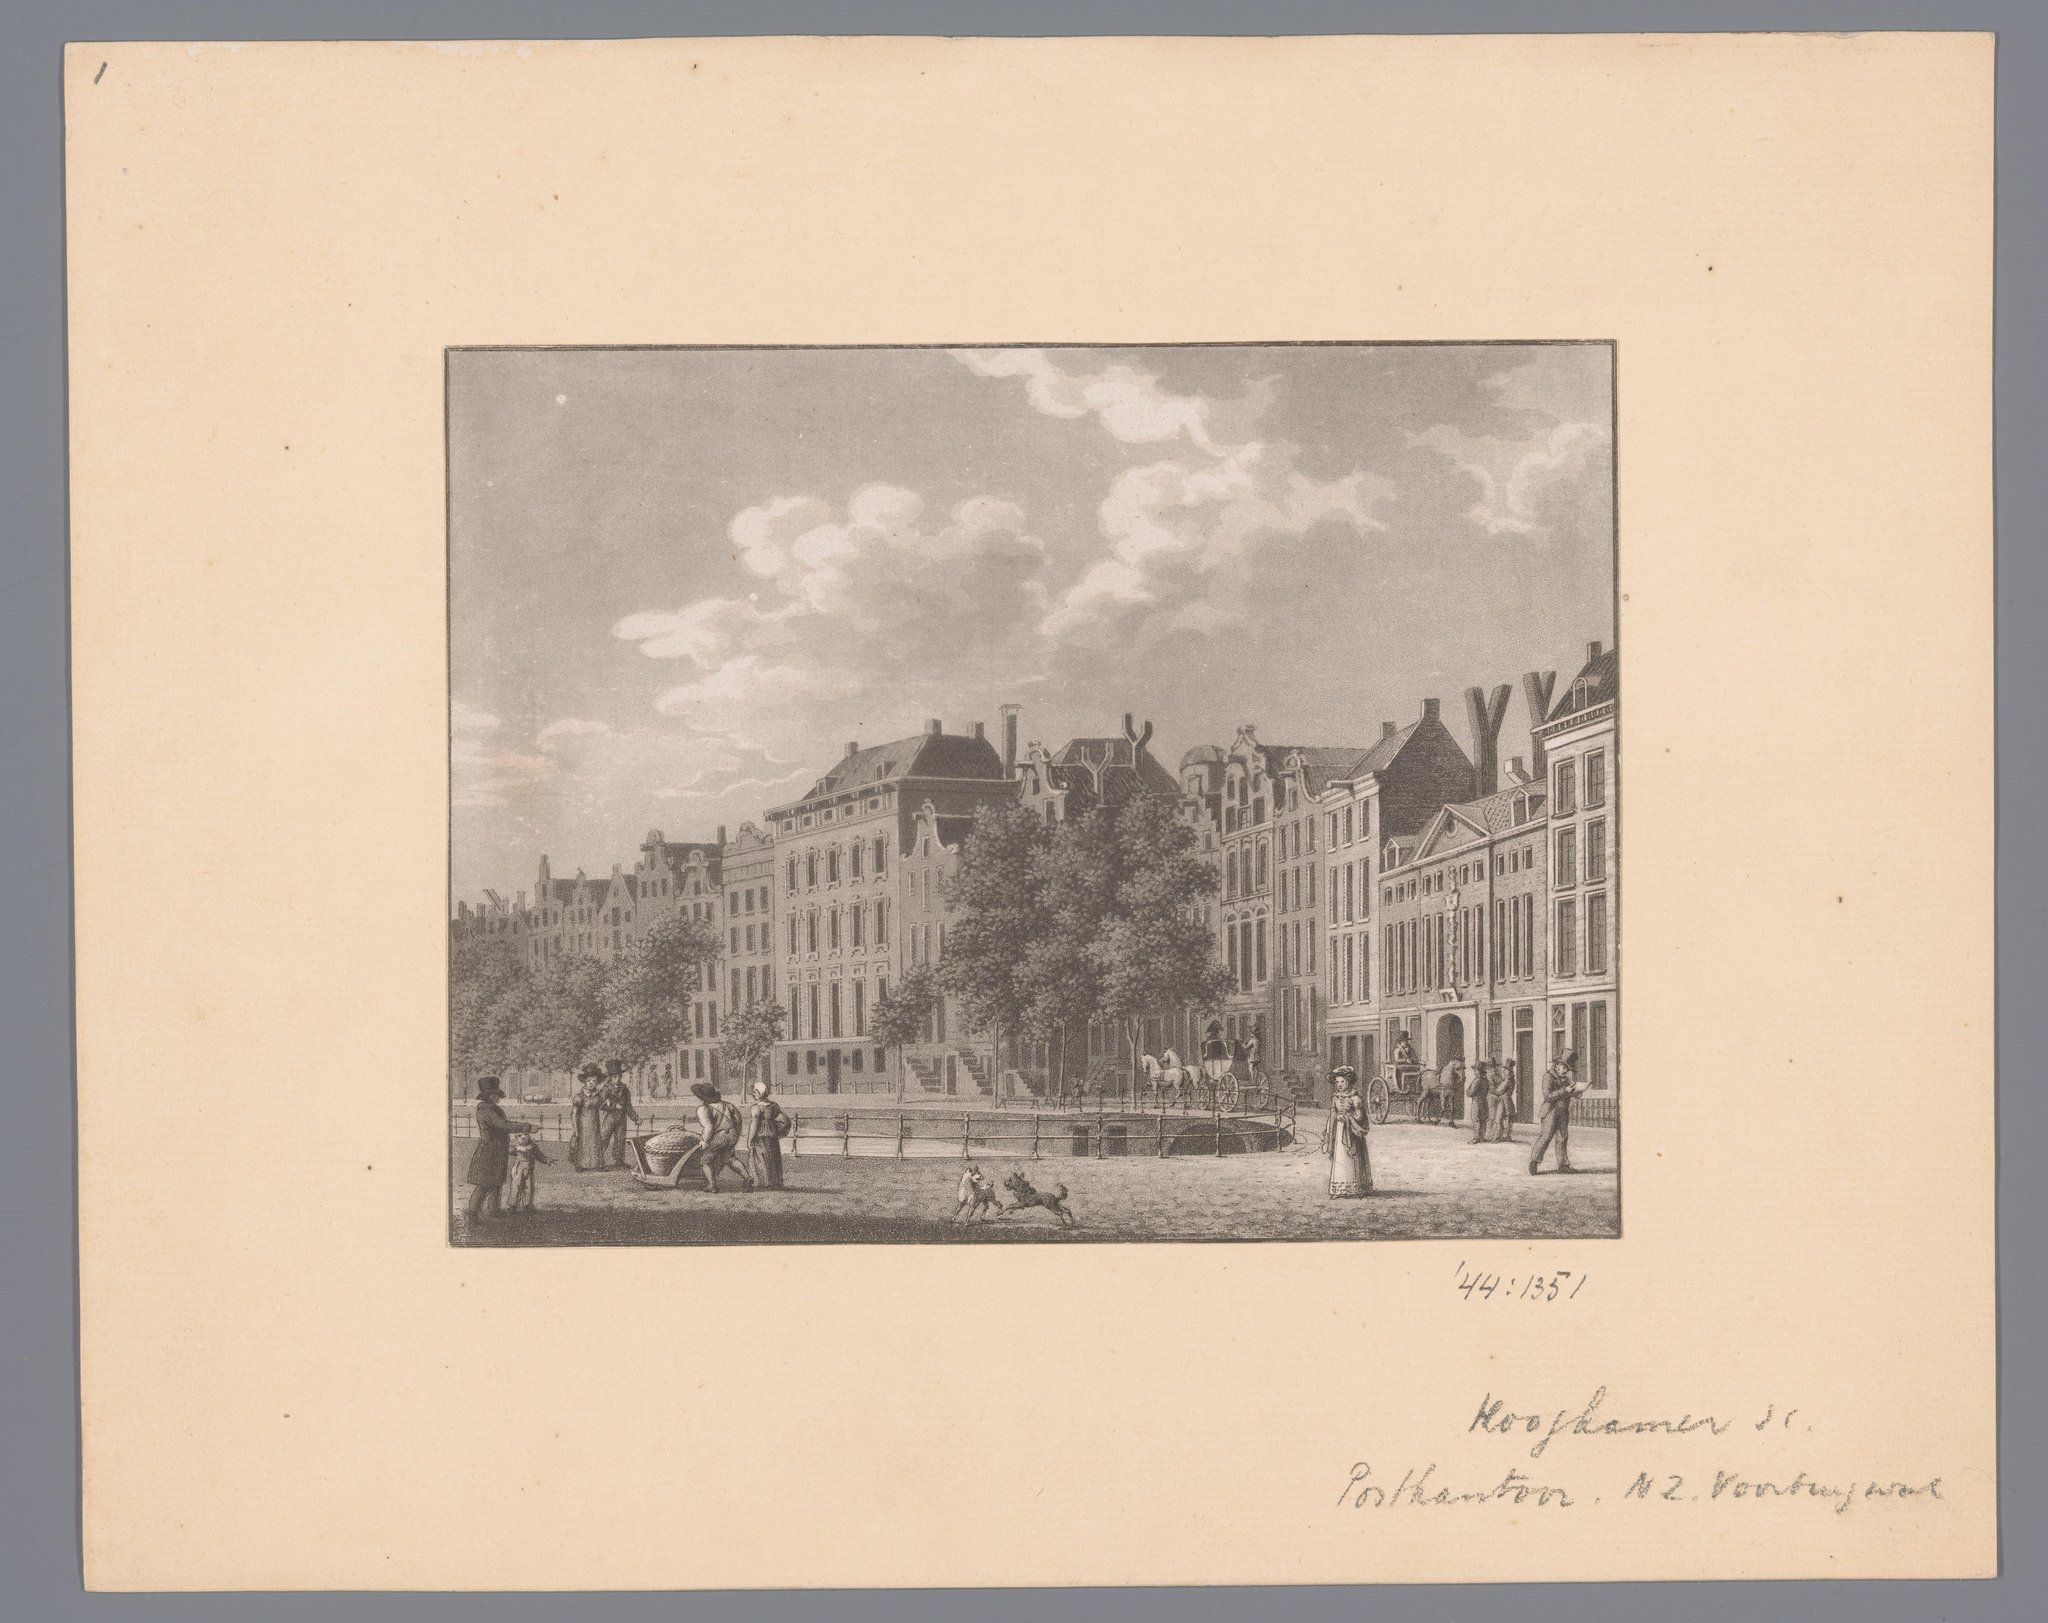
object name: print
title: Gezicht op de Nieuwezijds Voorburgwal te Amsterdam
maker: willem hendrik hoogkamer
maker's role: draughtsman, print maker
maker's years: 1790-1864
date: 1845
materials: paper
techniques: aquatint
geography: amsterdam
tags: canals, waters (in city), amsterdam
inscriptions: collector's mark: Lugt 2228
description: Prent verschenen in: Gezicht op de Maatschappij tot nut van het Algemeen te Amsterdam. Amsterdam: Frans Buffa & Zonen, [1845].